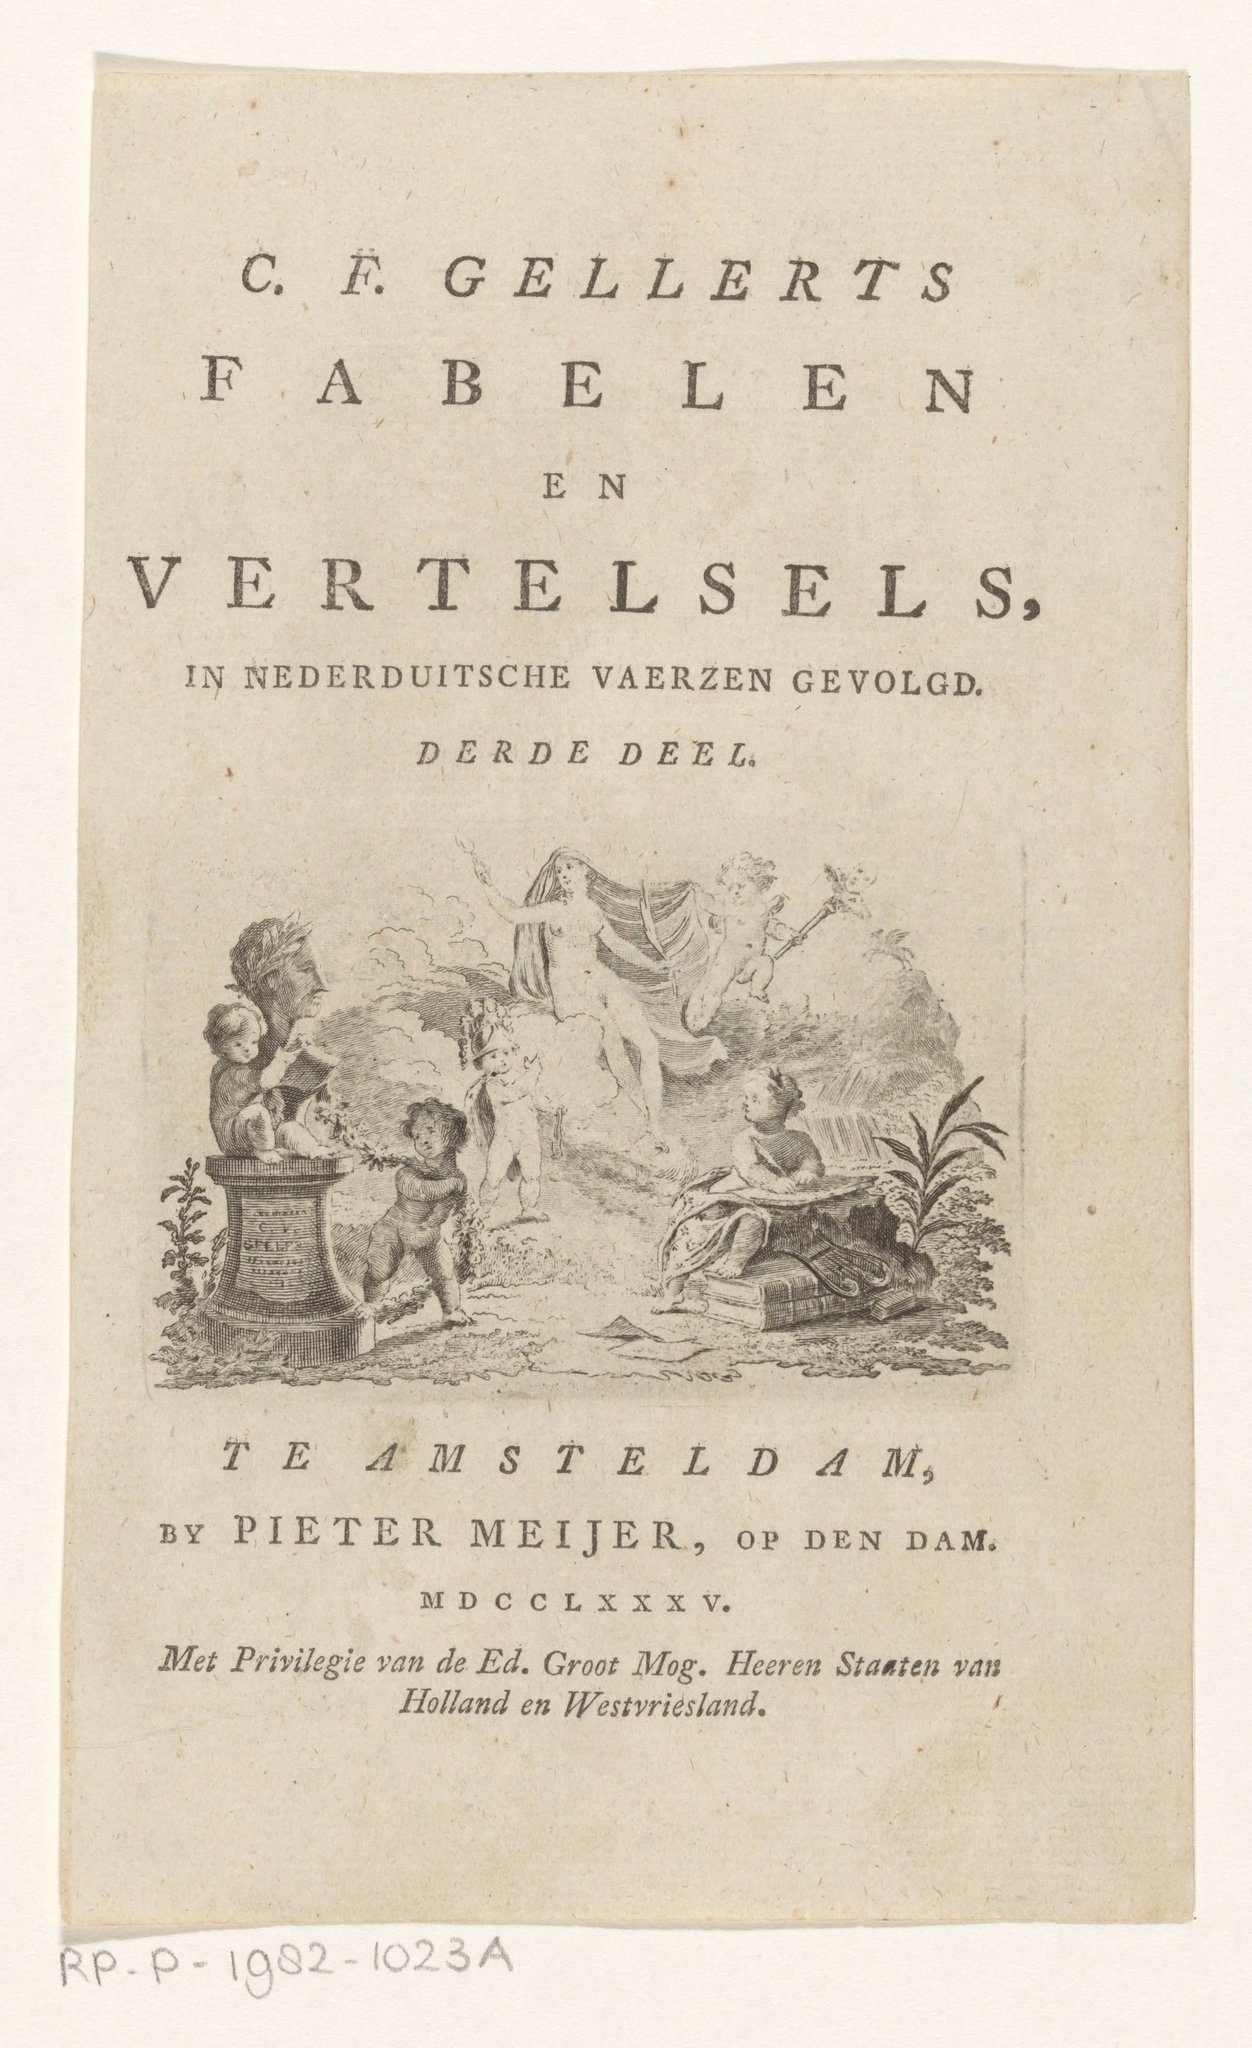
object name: print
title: Allegorische voorstelling met putti en buste van C.F. Gellert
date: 1785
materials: paper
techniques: engraving, etching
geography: amsterdam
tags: portrait of a writer, cupids: 'amores', 'amoretti', 'putti'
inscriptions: collector's mark: Lugt 2228, collector's mark: Lugt 2760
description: In een landschap links een portretbuste van de schrijver Christian Furchtegott Gellert op een voetstuk en twee putti met een guirlande. Rechts zit een putto, mogelijk Poesia, op boeken en schrijft. Daarachter twee putti en een gesluierde naakte vrouw op wolken.